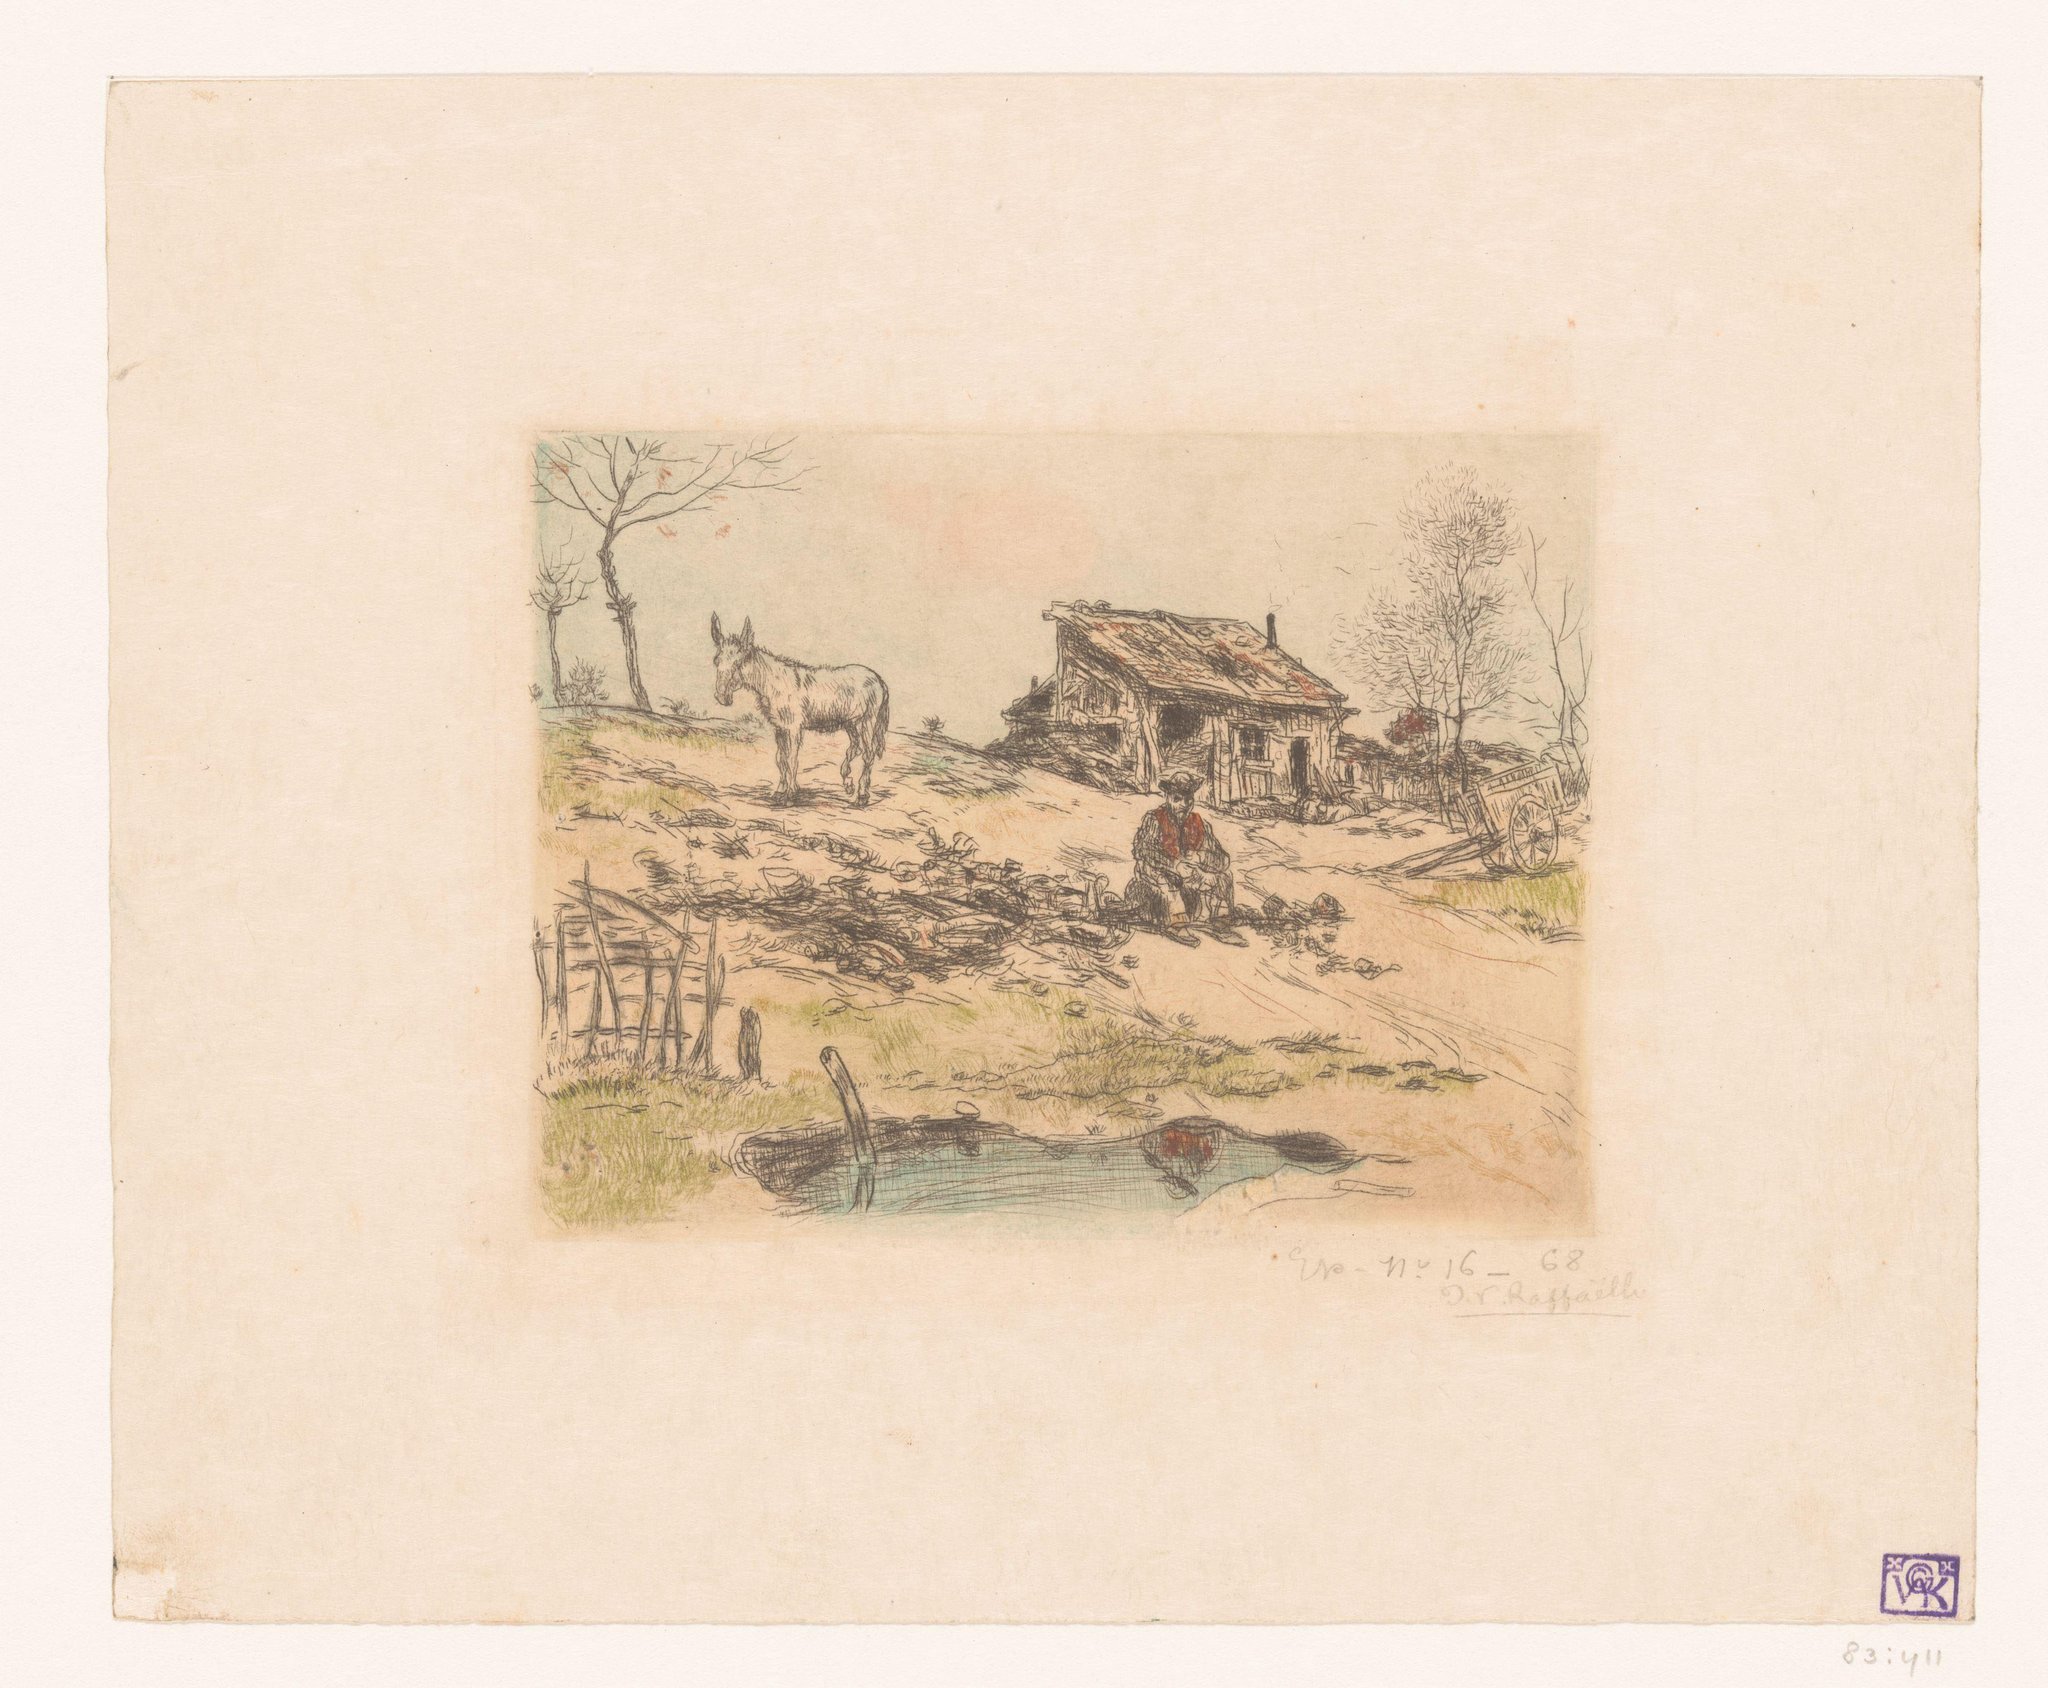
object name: print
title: La cabane du chiffonnier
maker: jean françois raffaëlli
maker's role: print maker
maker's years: 1850-1924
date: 1860-1924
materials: paper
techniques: color etching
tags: hut, cabin, lodge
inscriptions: collector's mark: Lugt 2113, collector's mark: Lugt 2760, collector's mark: Lugt 2521a, collector's mark: Lugt 2228, collector's mark: Lugt 1774b